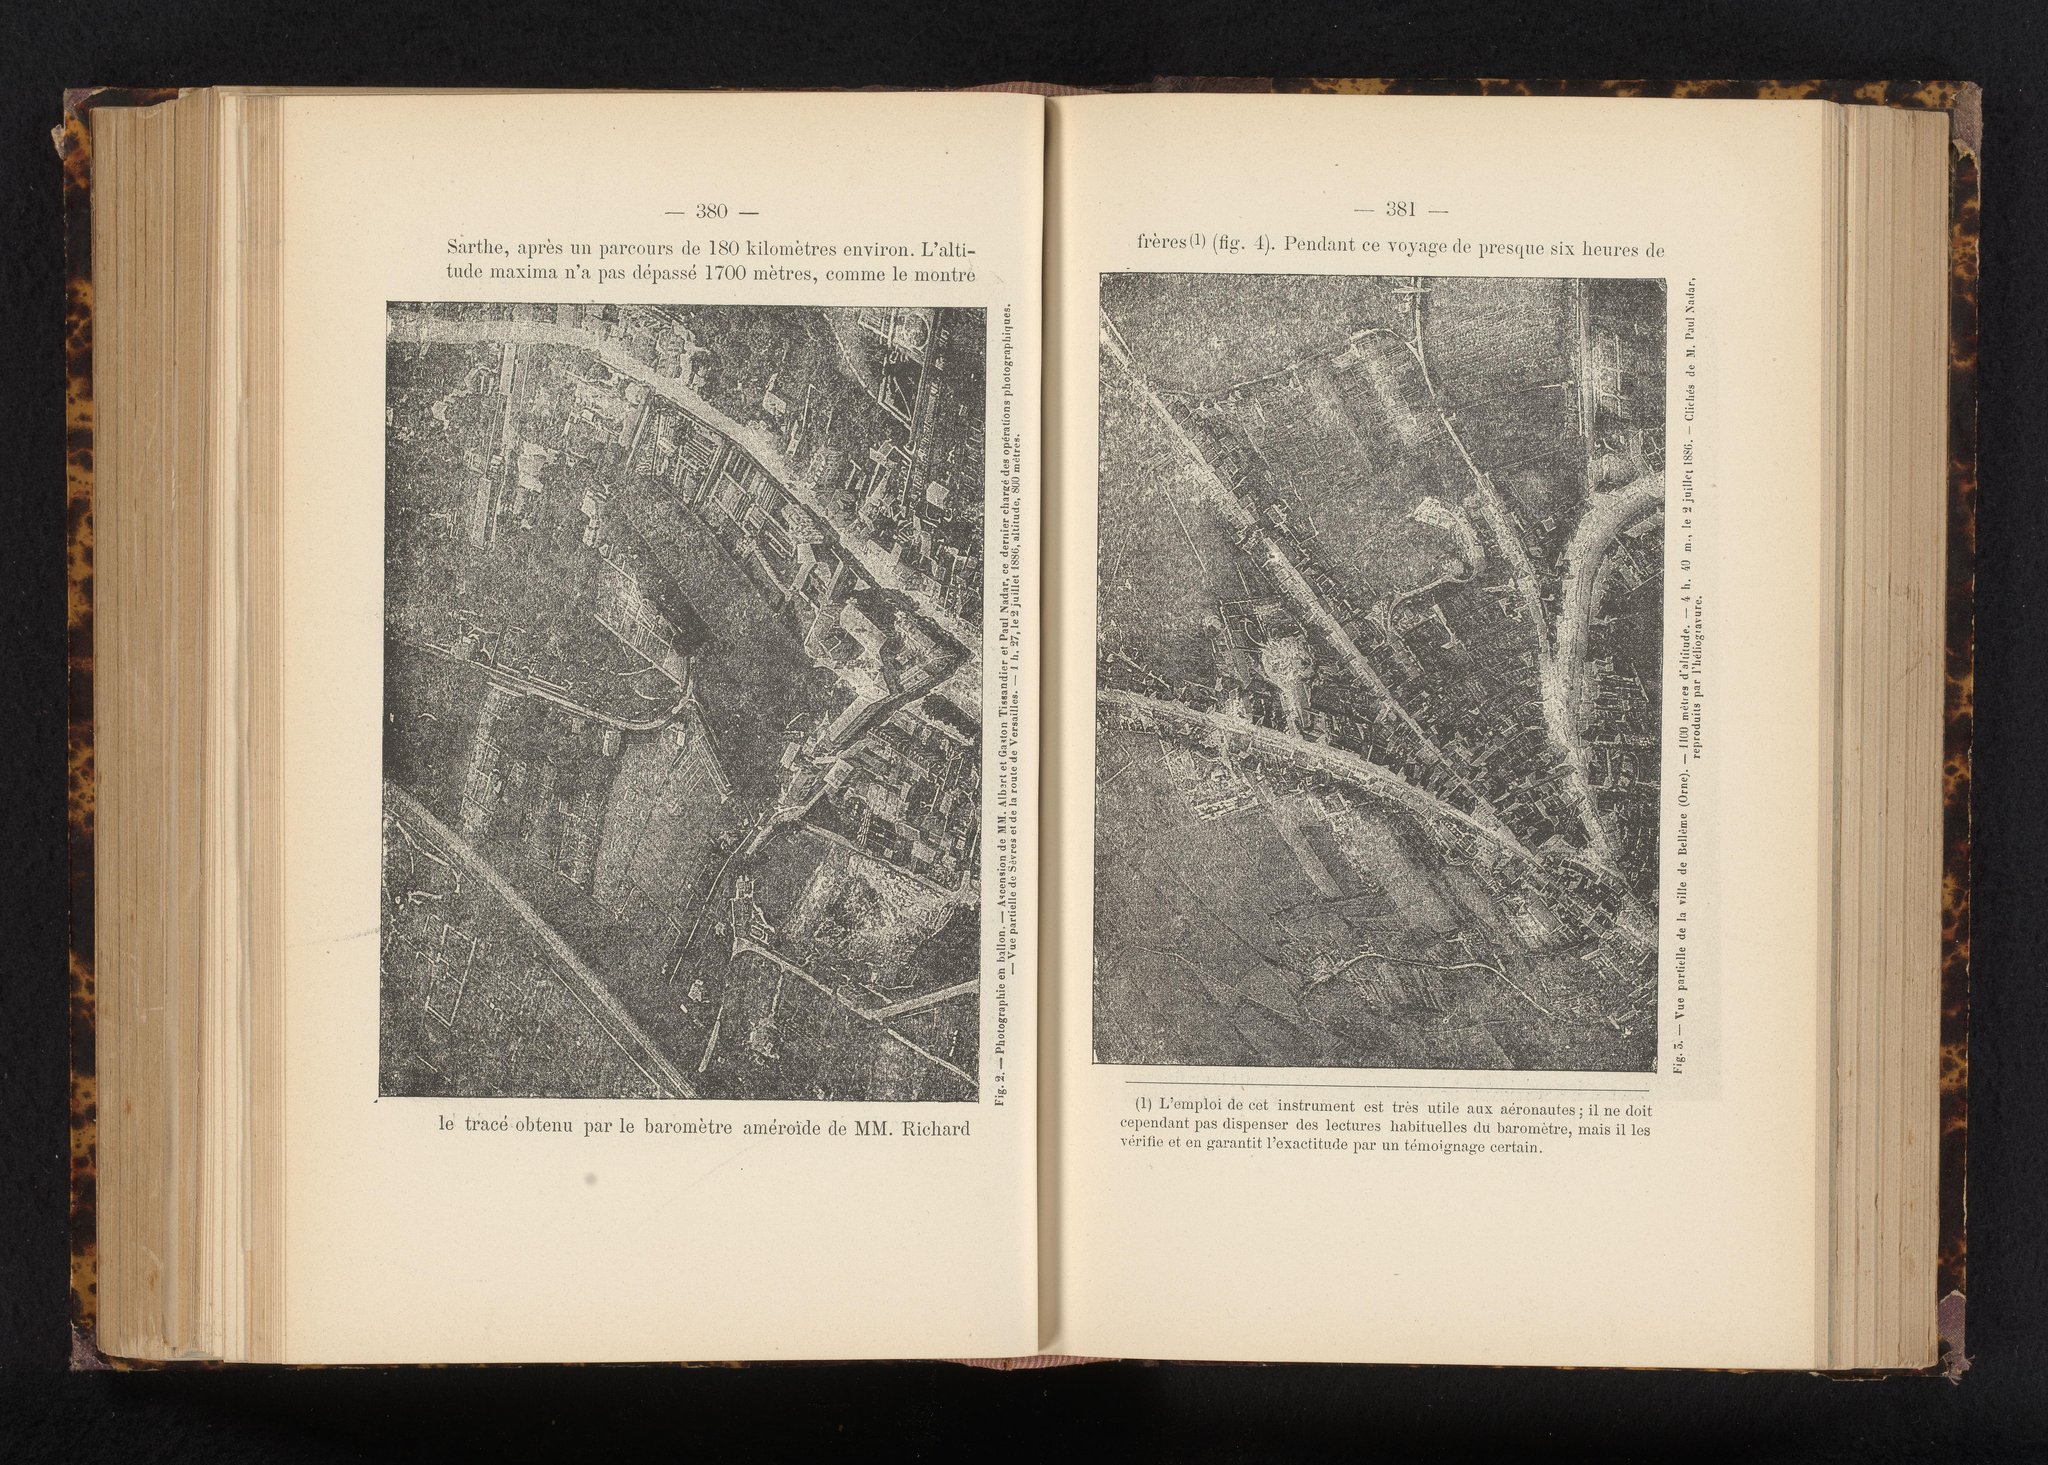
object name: page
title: Luchtfoto van Sèvres en de weg naar Versailles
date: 1886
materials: paper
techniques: photomechanical printing process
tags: city-view in general; 'veduta'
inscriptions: inscription: ‘Fig. 2.- (...) Ascension de (...) 800 mètres.’